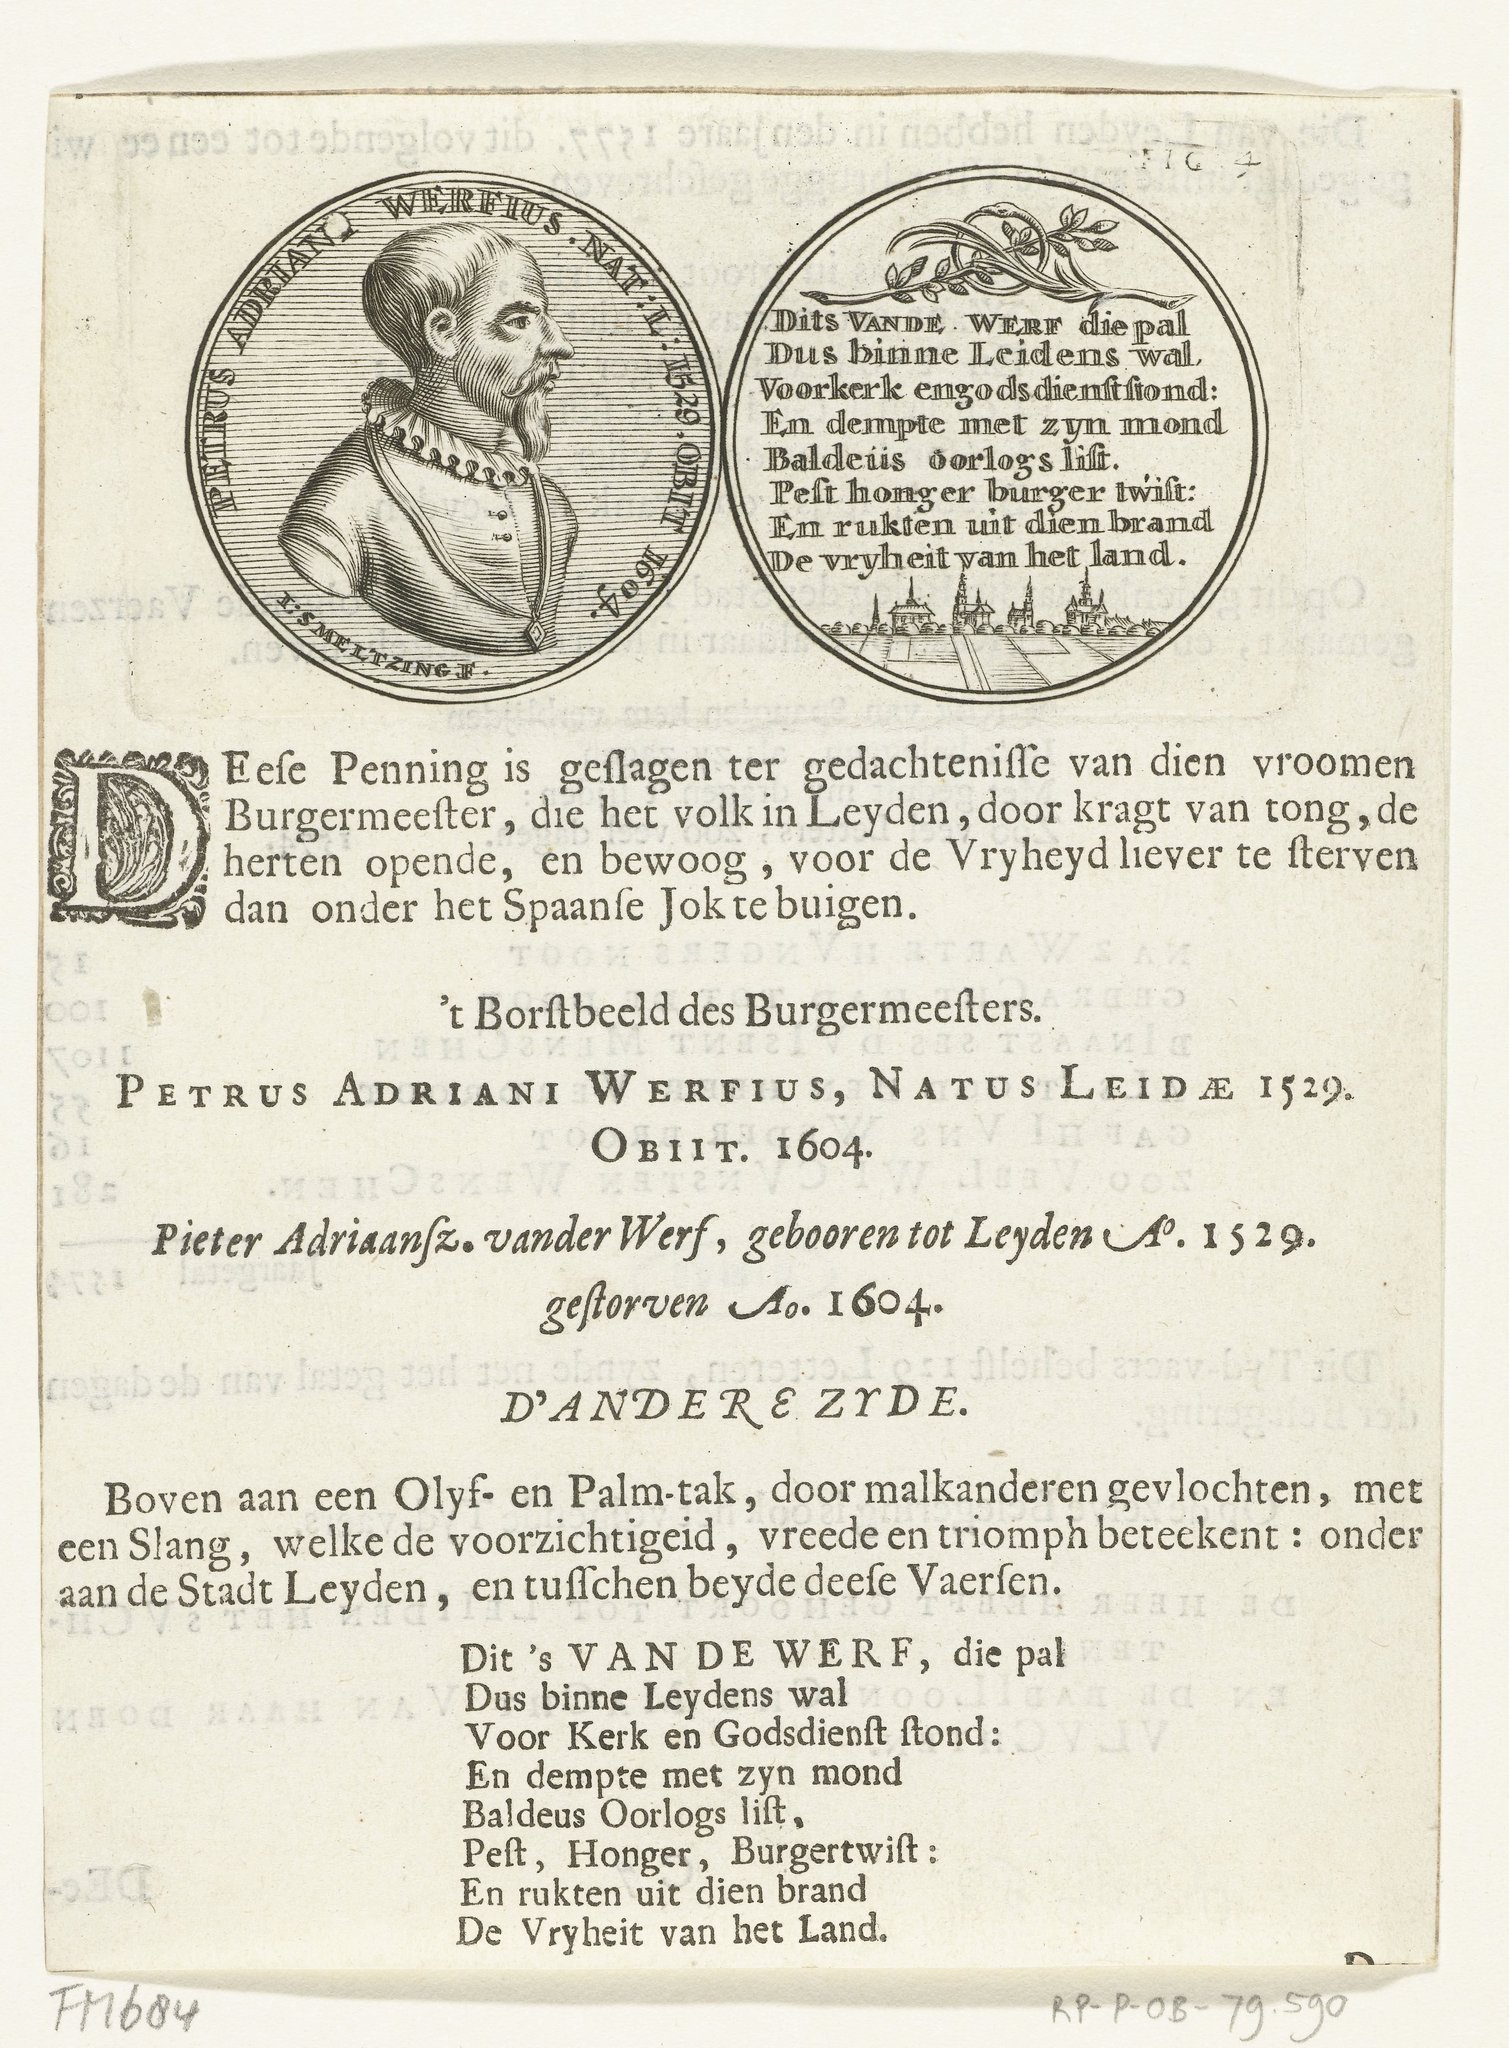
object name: print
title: Penning ter ere van burgemeester Pieter van der Werff, 1604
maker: Anonymous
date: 1700-1749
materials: paper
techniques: etching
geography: netherlands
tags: medal (considered as a piece of sculpture, regardless of its specific function), leiden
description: Penning met portret van burgemeester Pieter Adriaansz. van der Werff, bij zijn overlijden in 1604. Voorzijde: borstbeeld van Van der Werff binnen omschrift. Keerzijde: Vers boven gezicht op Leiden. Onder de prent en op achterzijde bedrukt met tekst in het Nederlands.